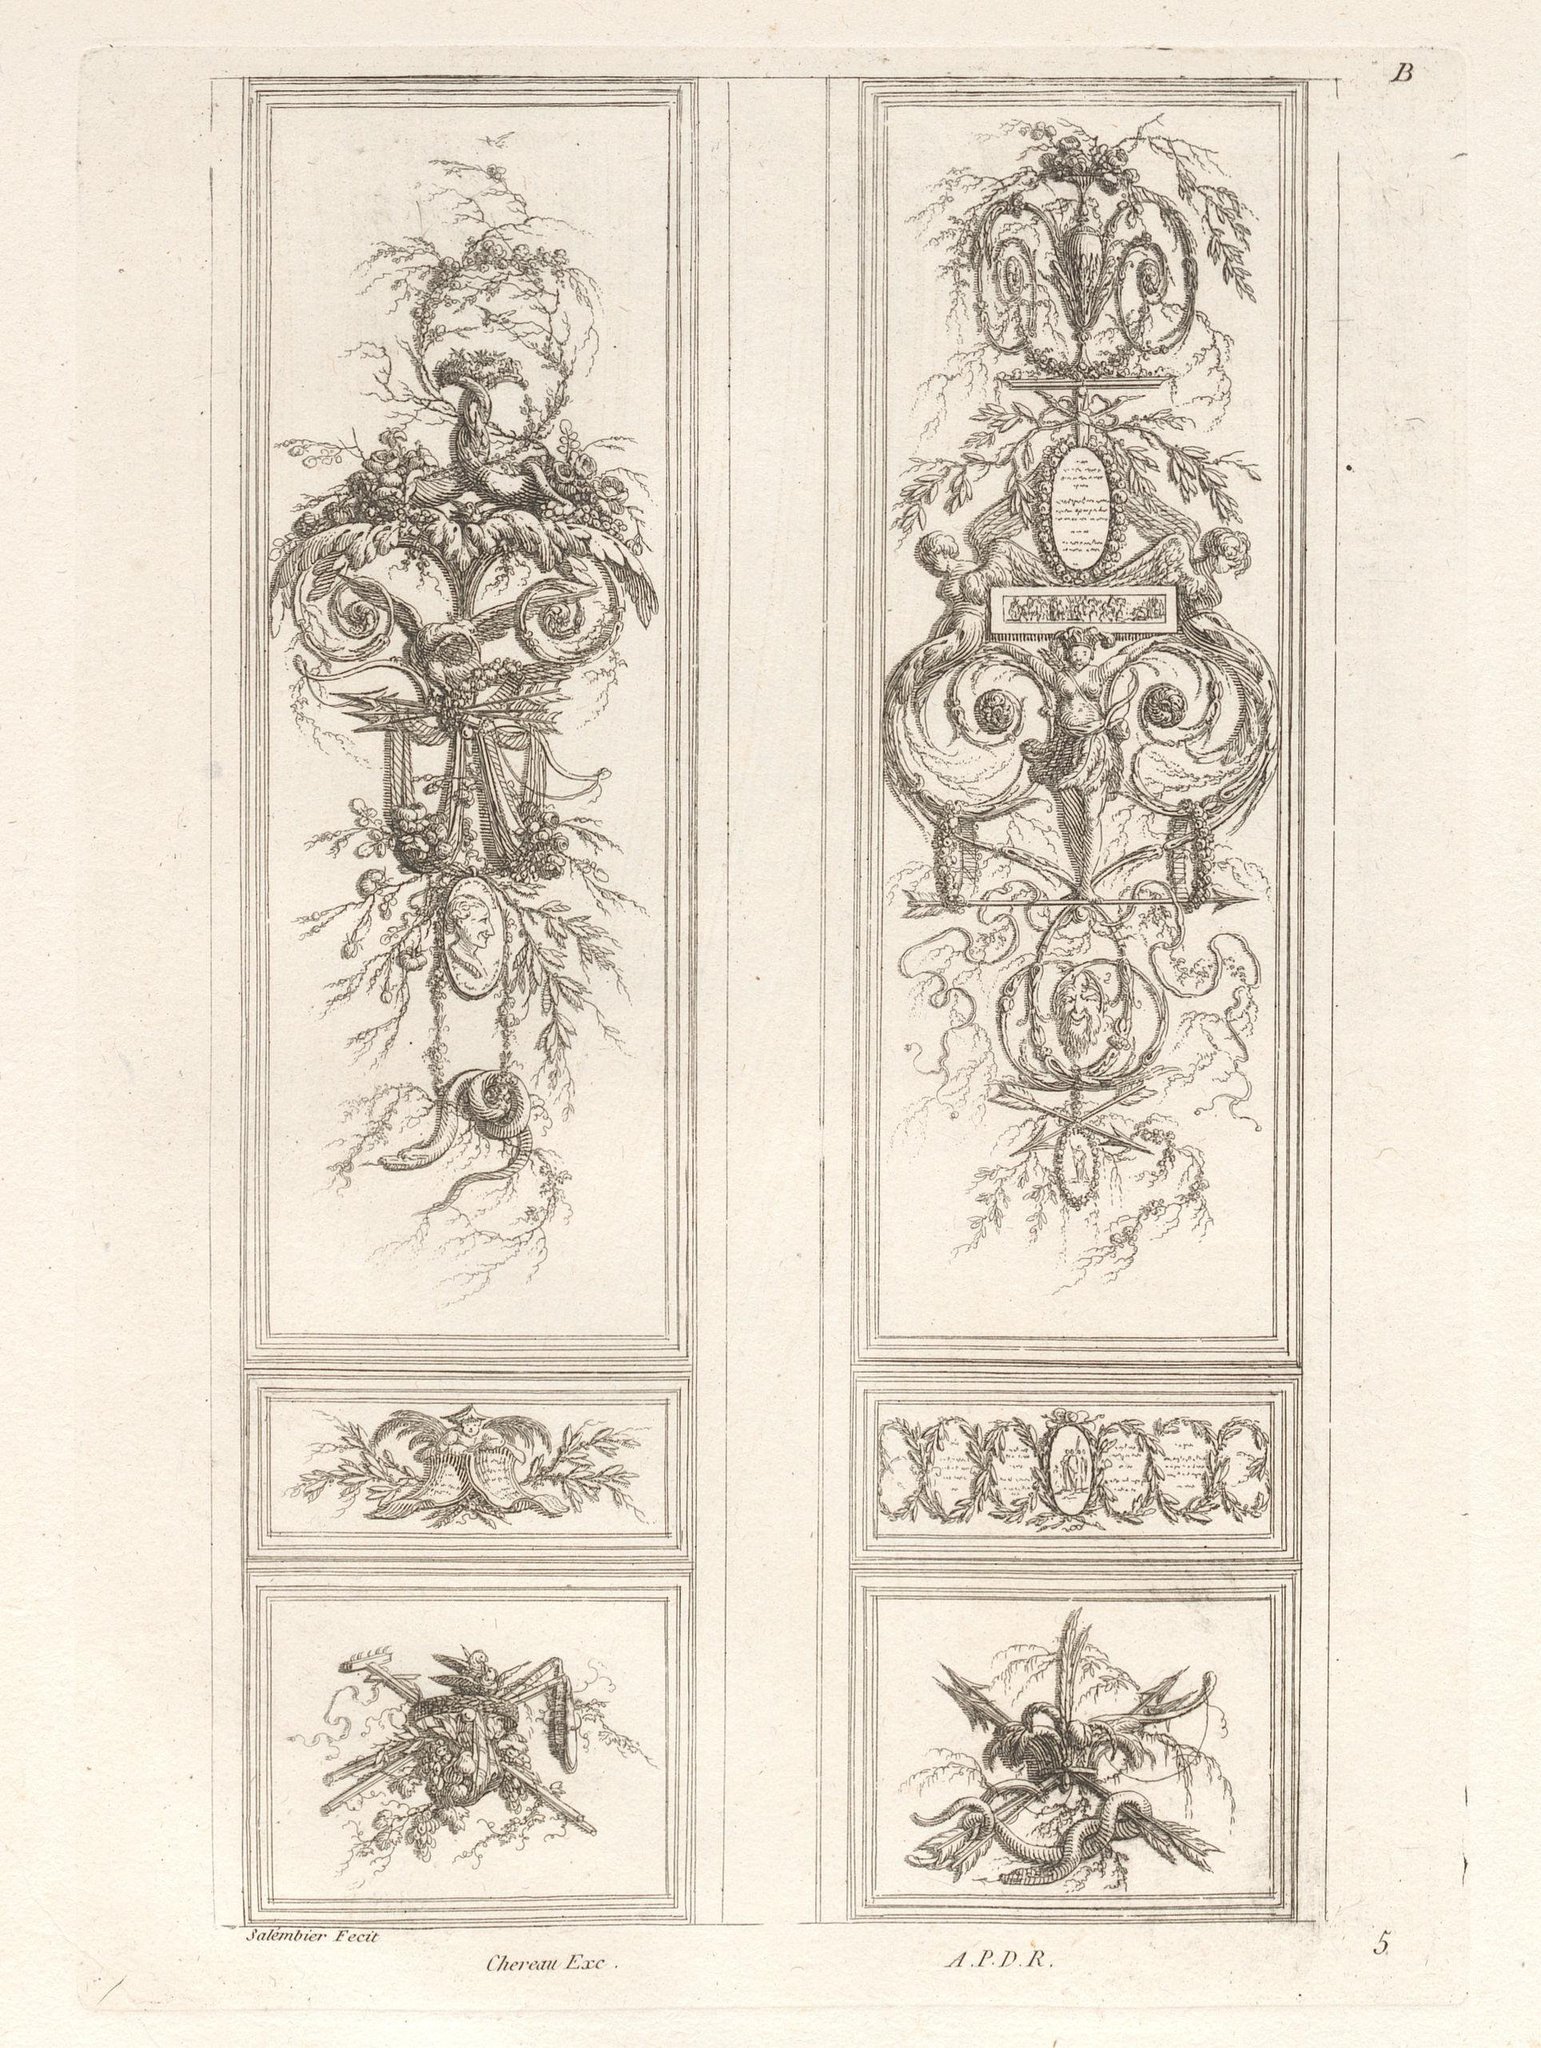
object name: album leaf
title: Cahier d'arabesques, composées et gravés par Salembier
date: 1802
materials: paper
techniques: etching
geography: paris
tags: snakes, 'cornucopia', horn of plenty, ornament ~ arabesque, archer's weapons: arrow, agricultural implements, ornament derived from plant forms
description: Doordat dit album bestaat uit meerdere, deels eerder uitgegeven prentreeksen, is de datering niet consequent. Het geheel is op de titelpagina gedateerd op 1802. Deze reeks is niet afzonderlijk gedateerd. De serietitel voor het gehele werk is "Recueil d'arabesques, contenant les loges du Vatican". De andere serietitel is de titel van de specifieke reeks binnen het geheel.